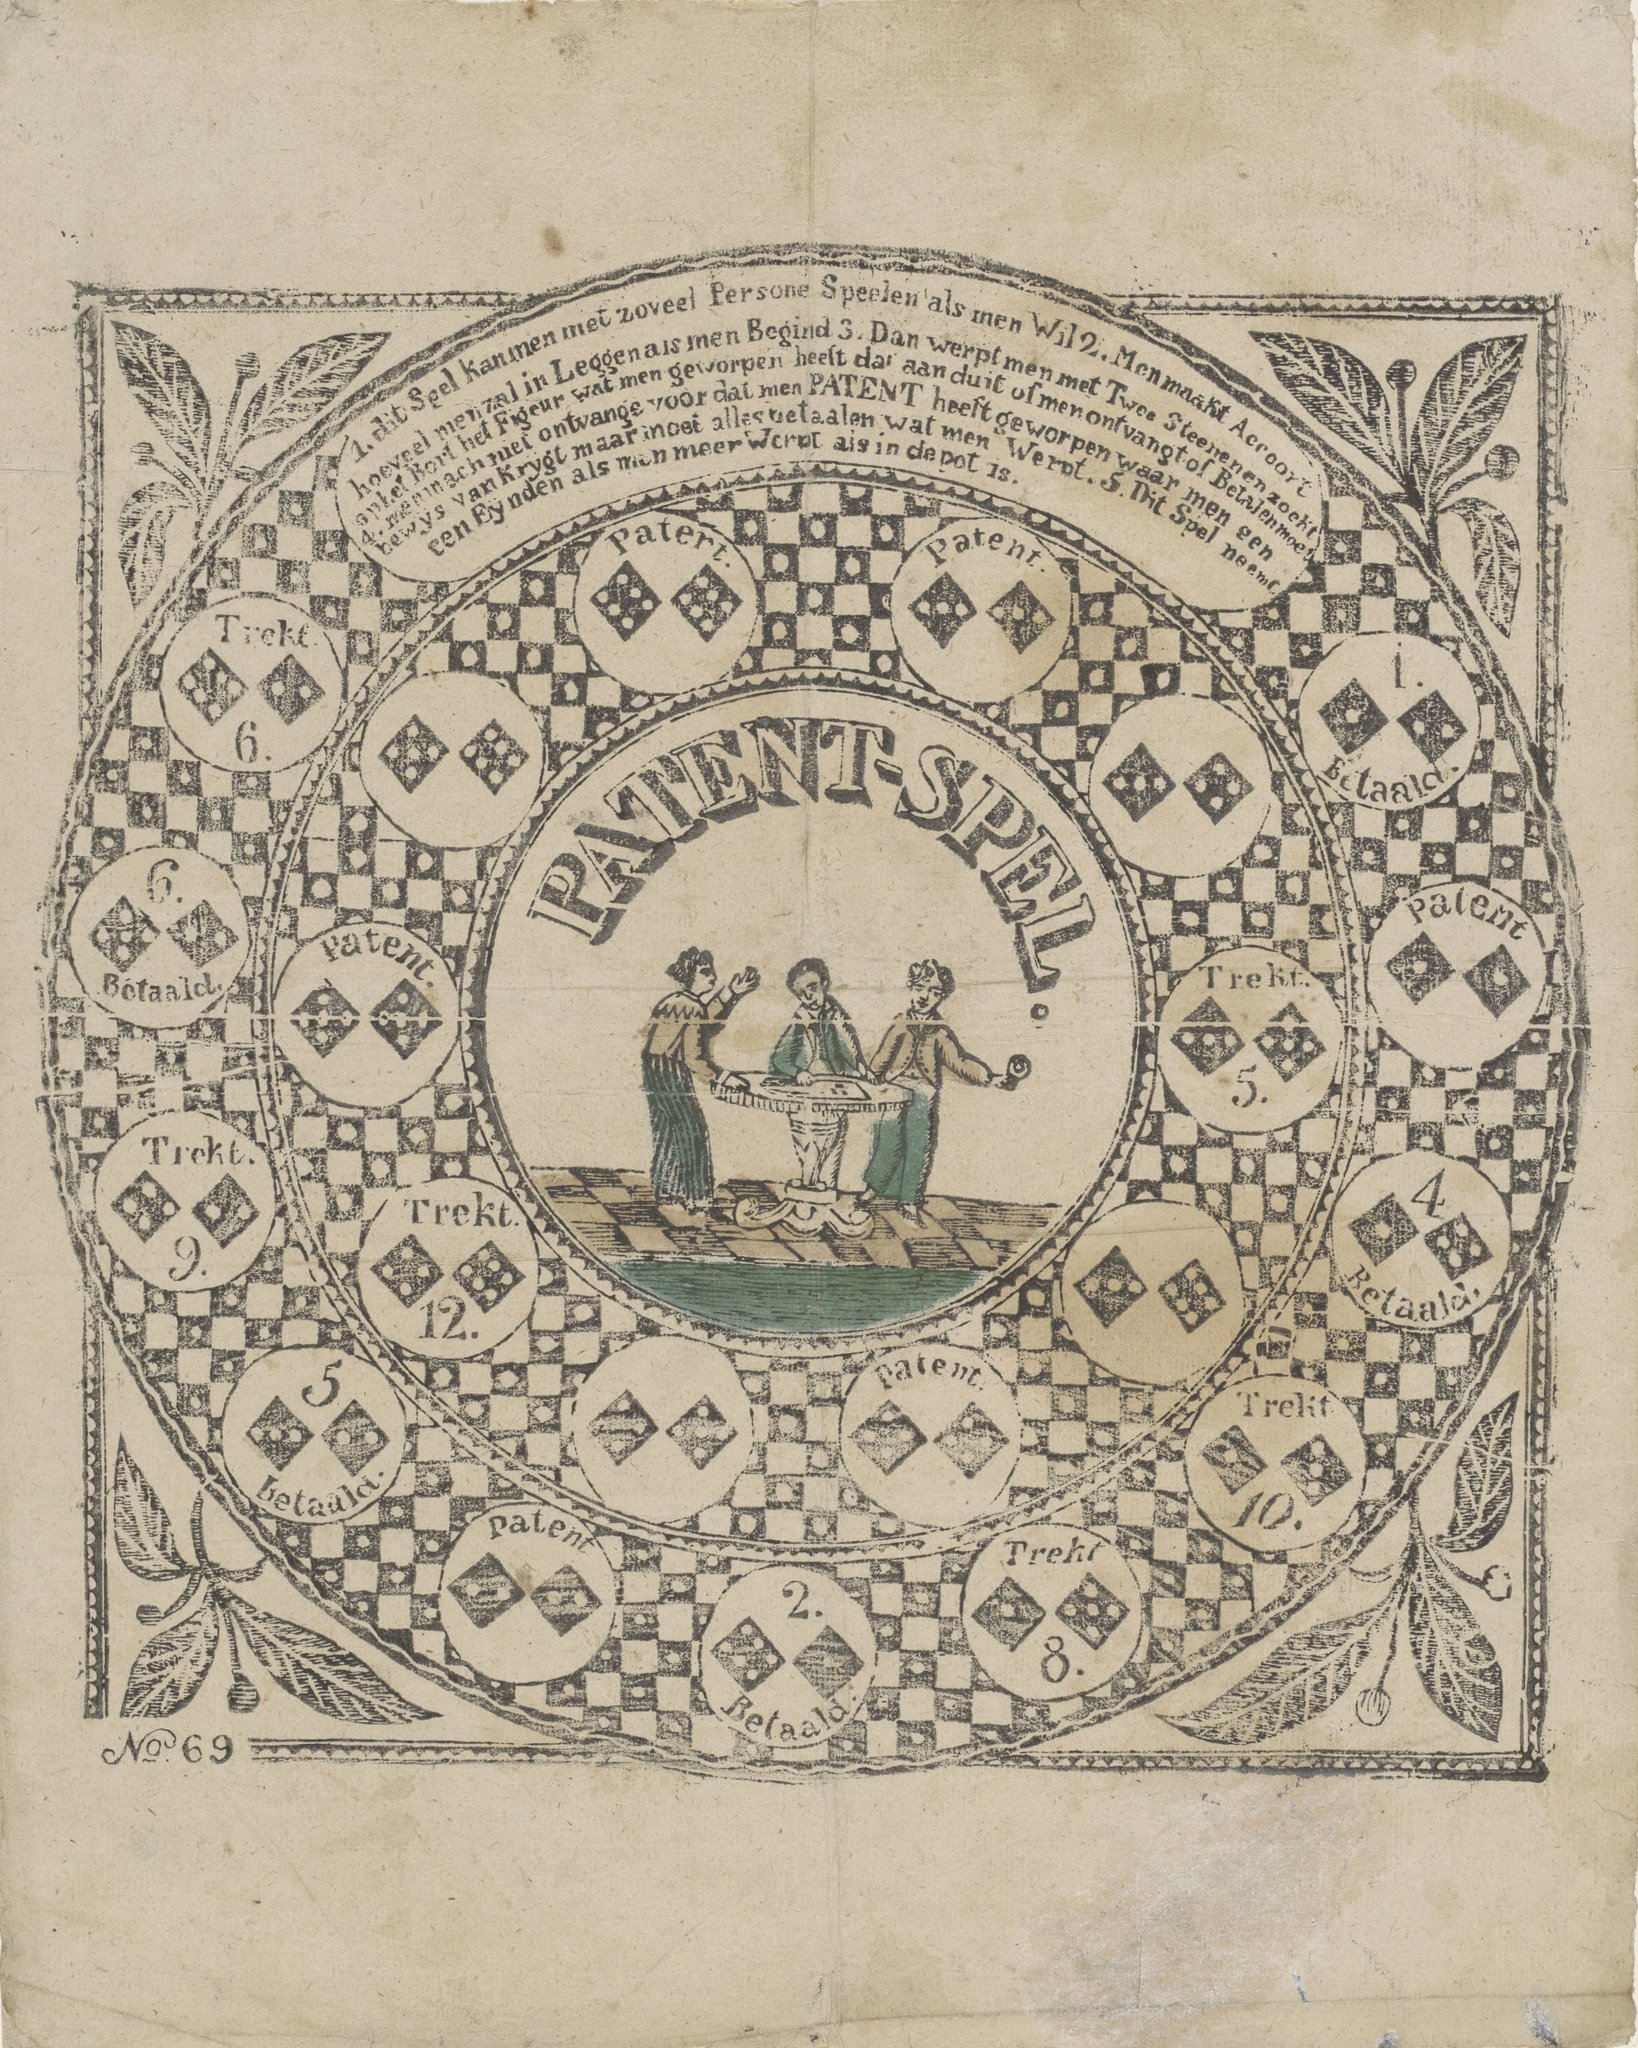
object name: popular print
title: Patent-spel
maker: Anonymous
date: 1700-1899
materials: paper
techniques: colour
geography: netherlands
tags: board-games of chance, board-games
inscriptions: collector's mark: Lugt 2760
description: Cirkelvormig bordspel met vakjes met dobbelstenen. Op het middenveld een voorstelling van spelende kinderen bij een tafel. Midden boven de spelregels. Genummerd linksonder: No. 69.